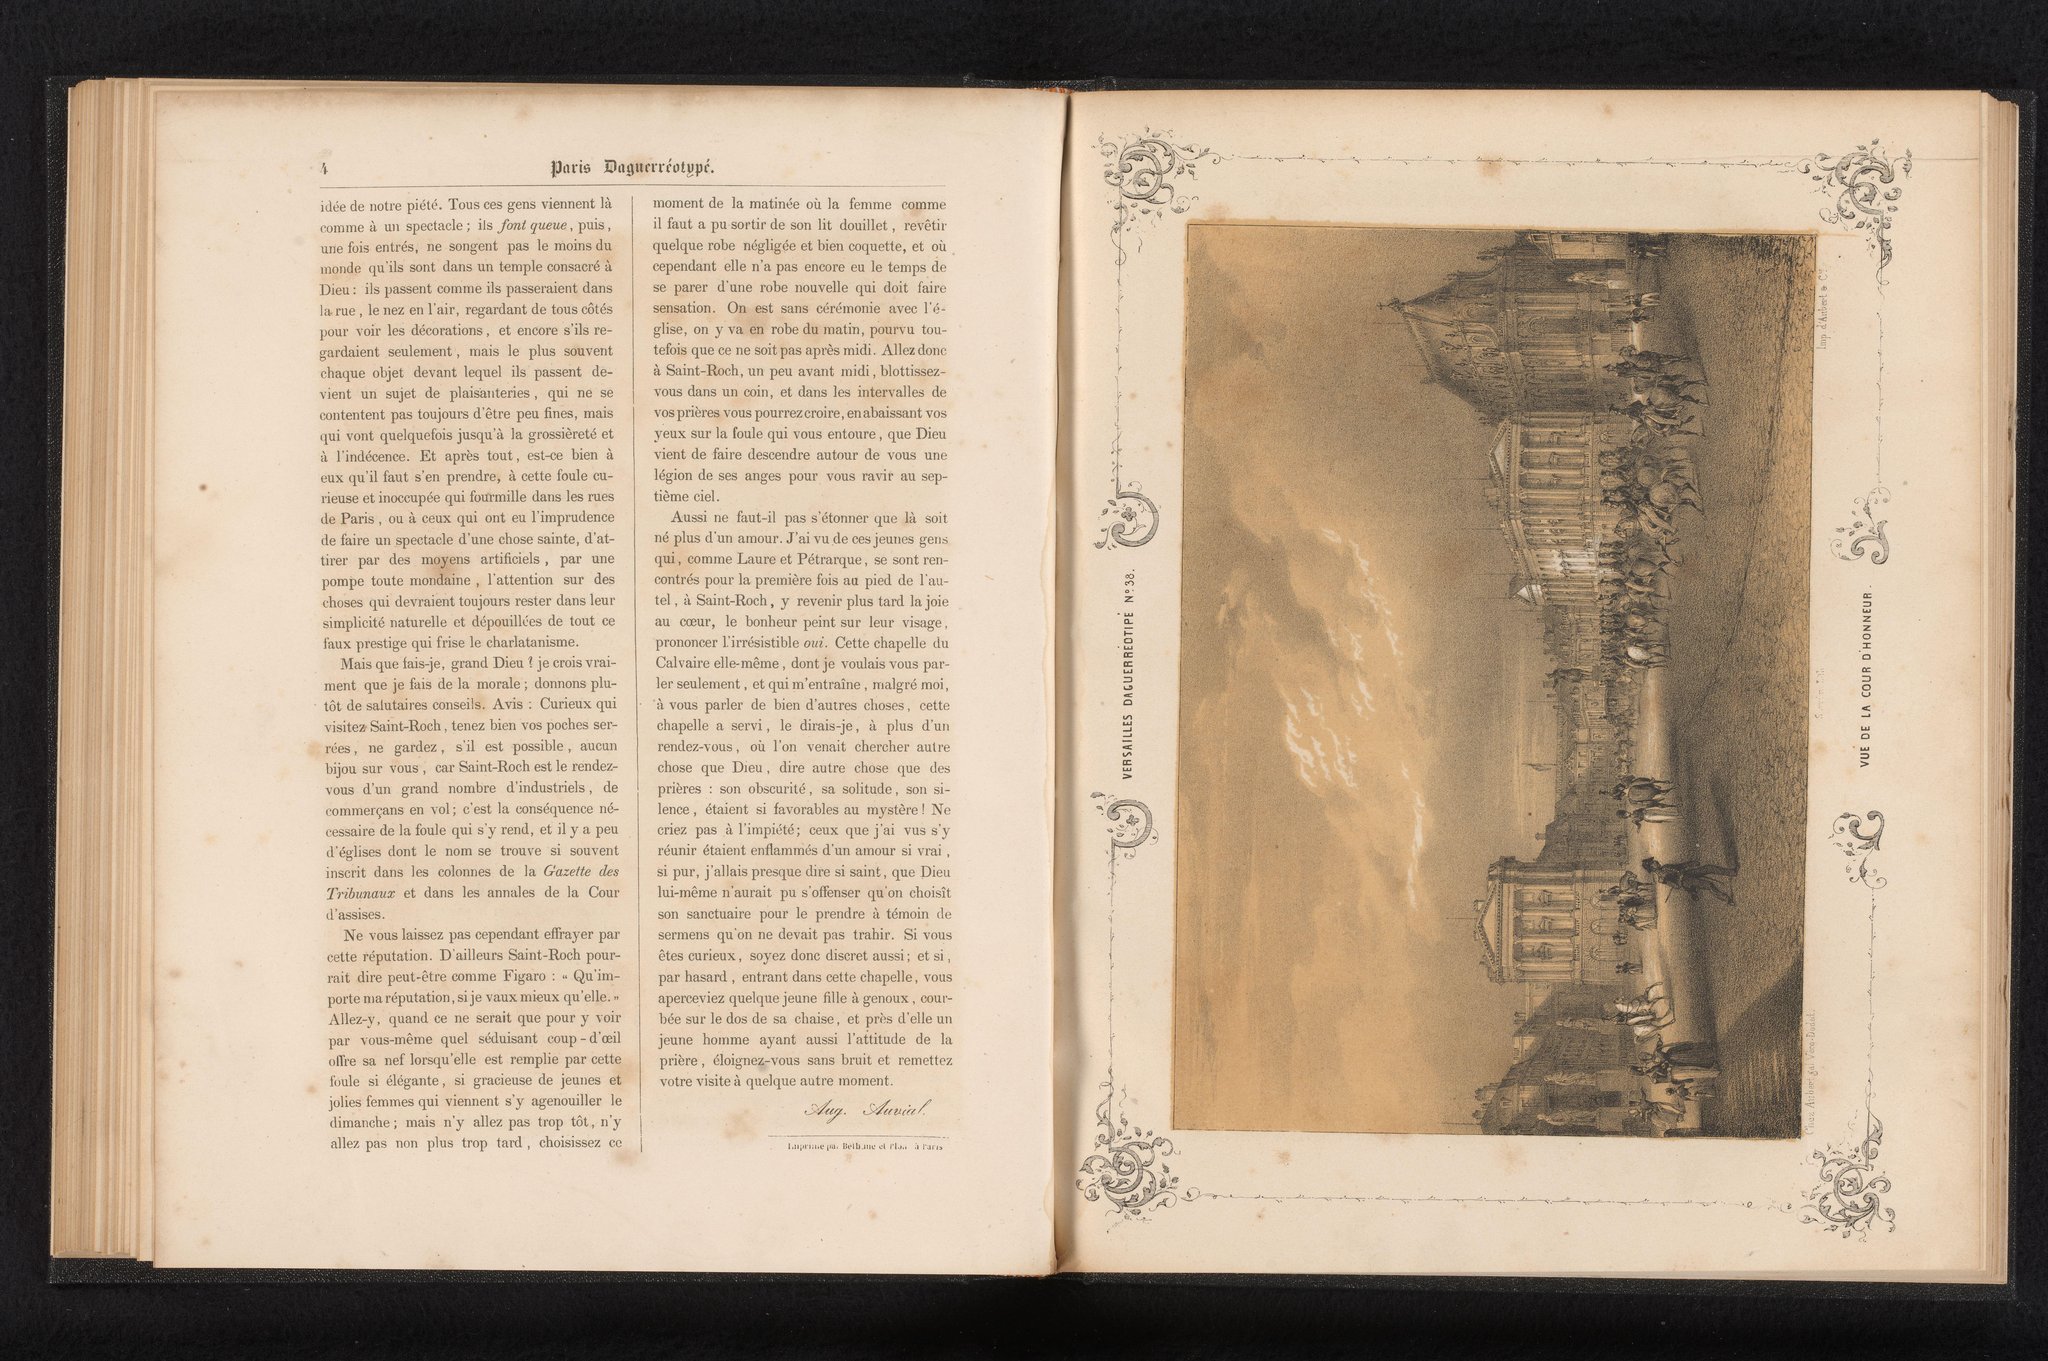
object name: print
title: Gezicht op het Kasteel van Versailles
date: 1839-1840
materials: paper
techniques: tone lithography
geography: paris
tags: palace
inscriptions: inscription: ‘VERSAILLES DAGUERRÉOTYPÉ No. 38.’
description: Prent op honderdeenenvijftigste ongenummerde pagina.